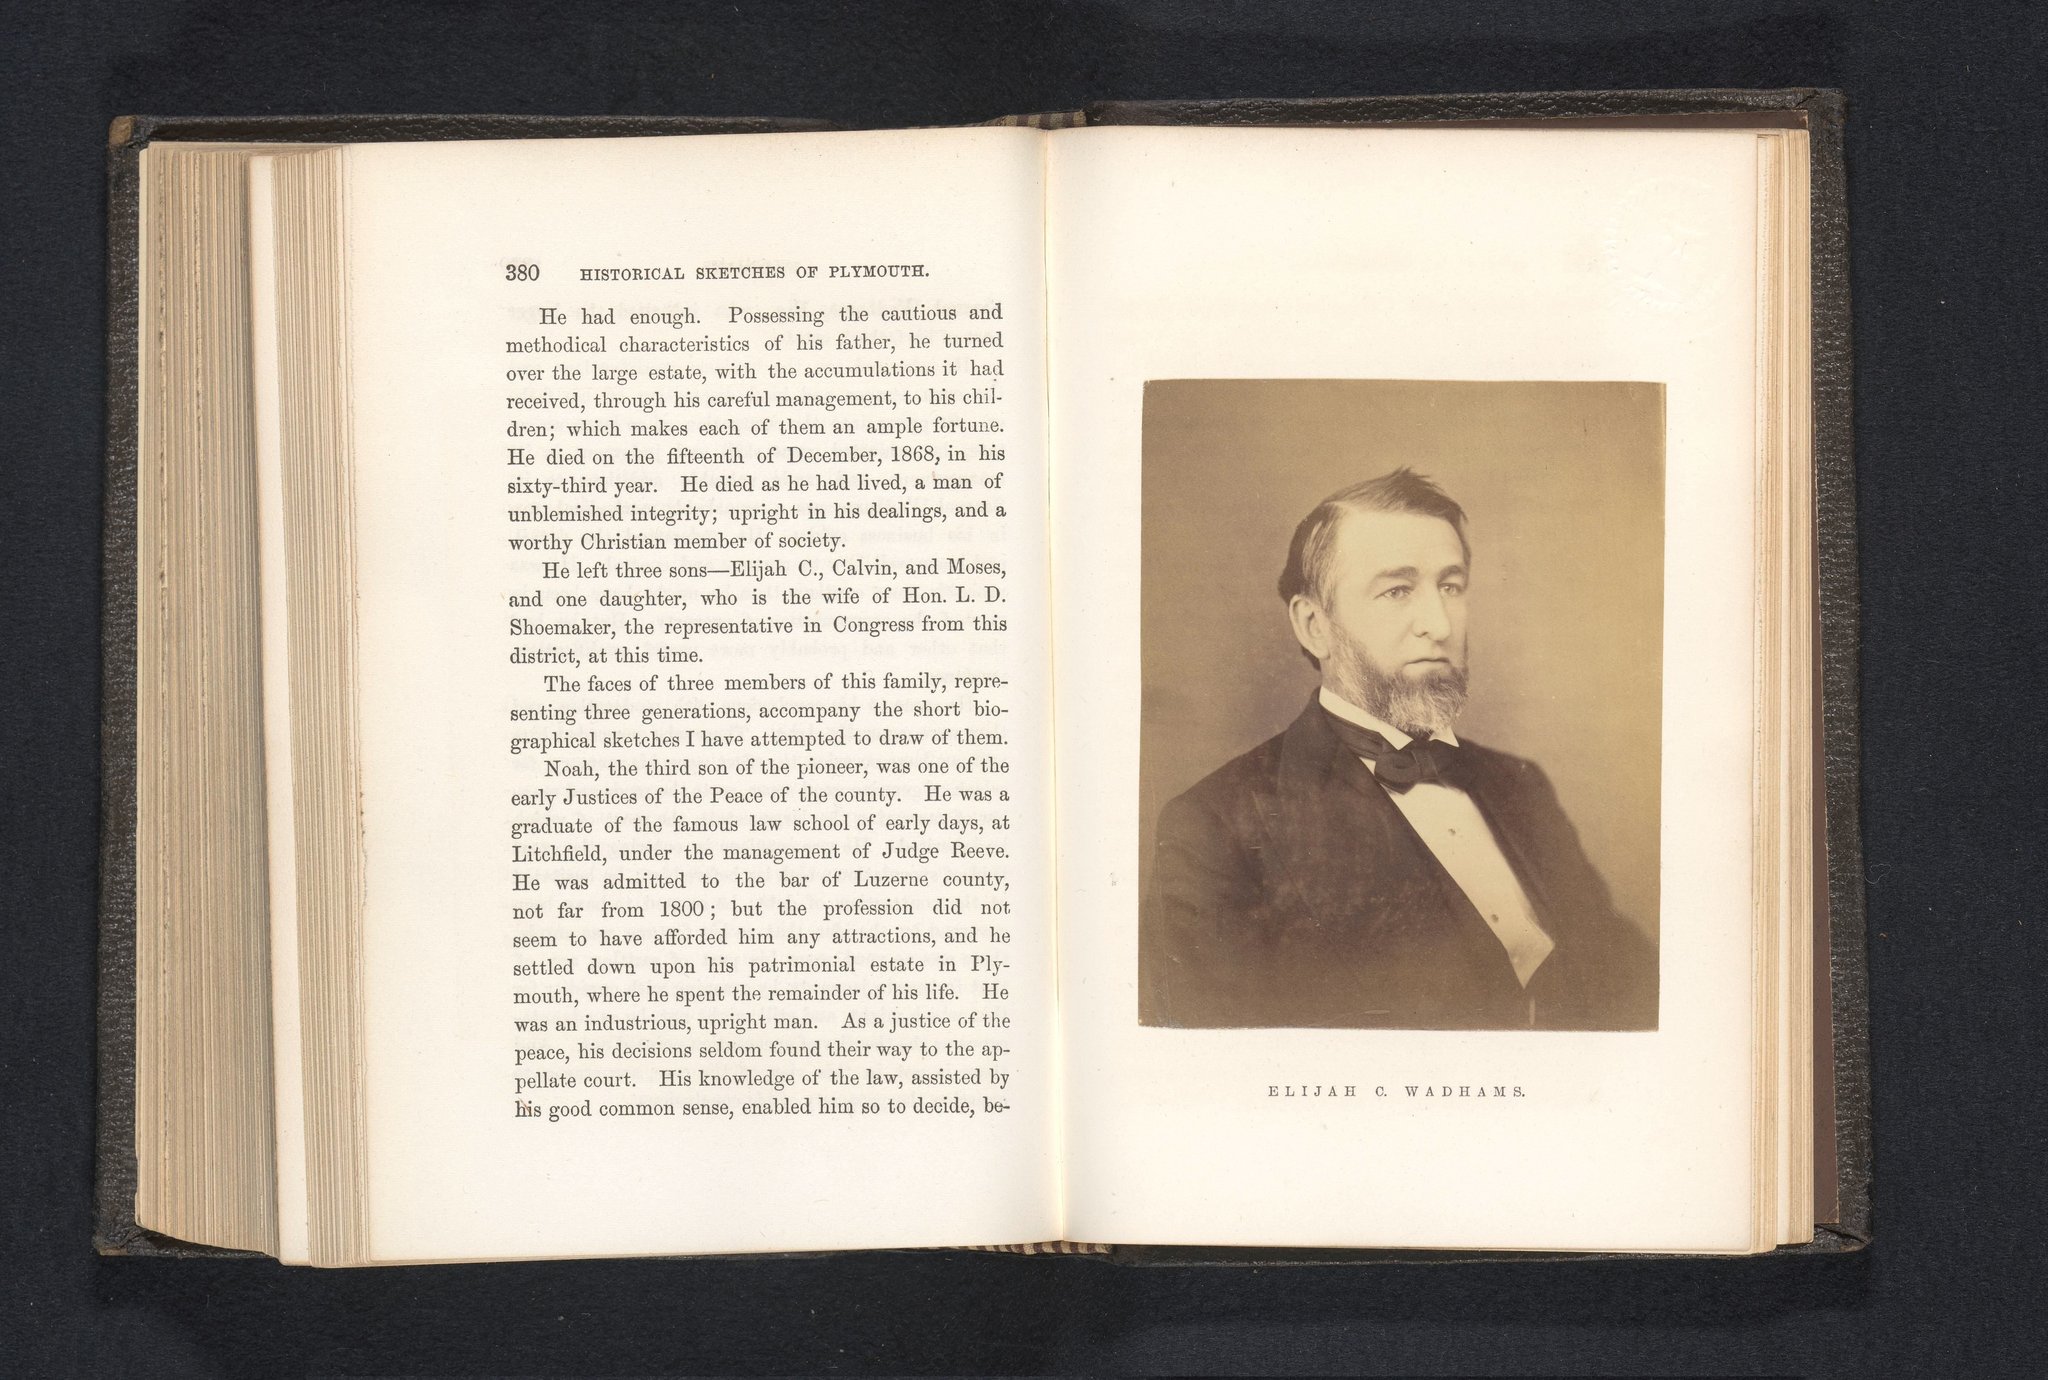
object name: page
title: Elijah C. Wadhams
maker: william h. schurch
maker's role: fotograaf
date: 1868-1873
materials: photographic support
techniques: albumen print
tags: historical persons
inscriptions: collector's mark: ‘Essex Institute 1848’